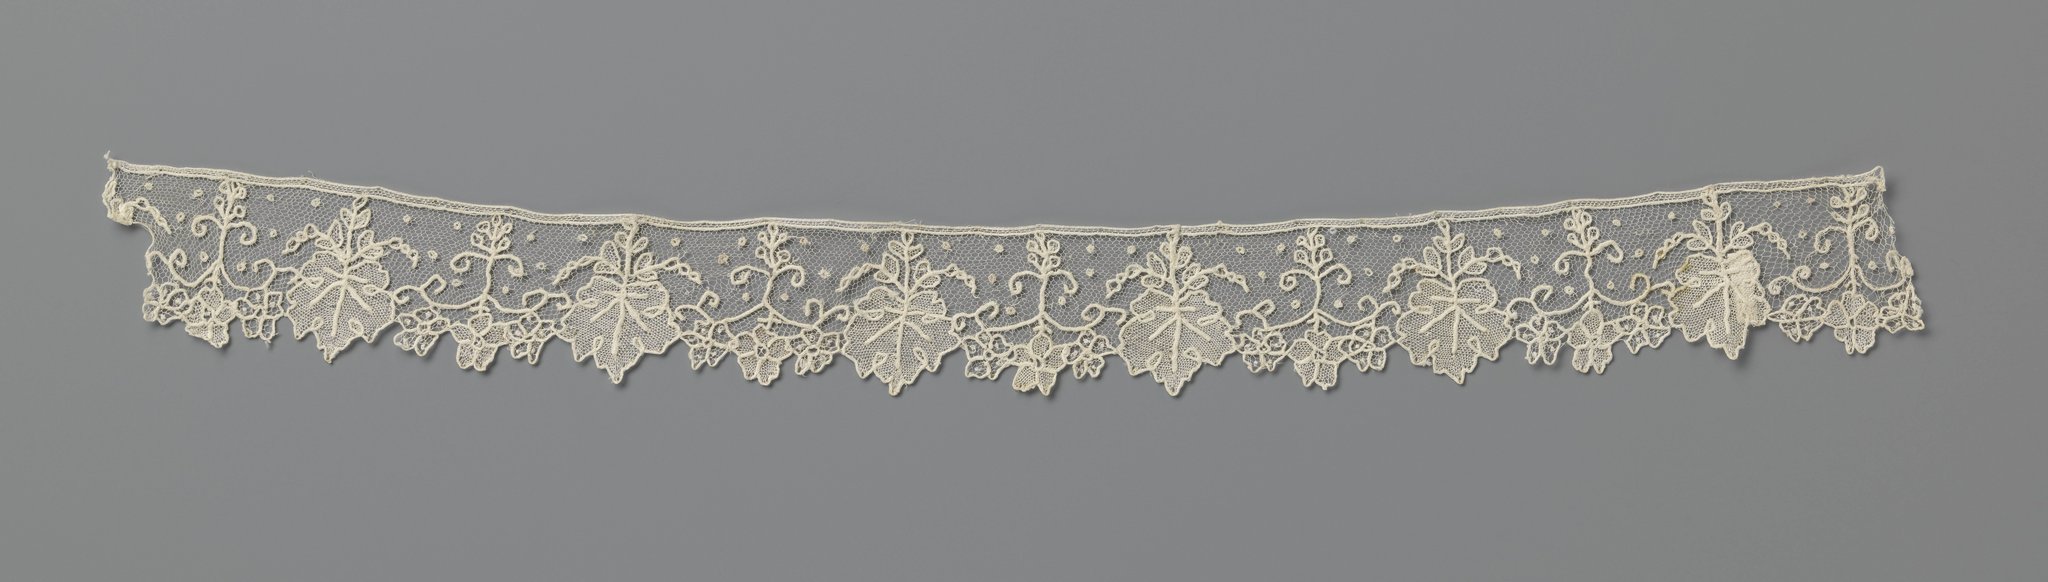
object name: strip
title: Strook naaldkant met klimopblaadjes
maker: Anonymous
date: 1850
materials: linen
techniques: needle lace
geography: brussels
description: Grote wingerdbladeren van een staand recht takje worden afgewisseld met dito takje waarvan drie viooltjes naar beneden hangen. Point de gaze de Bruxelles.